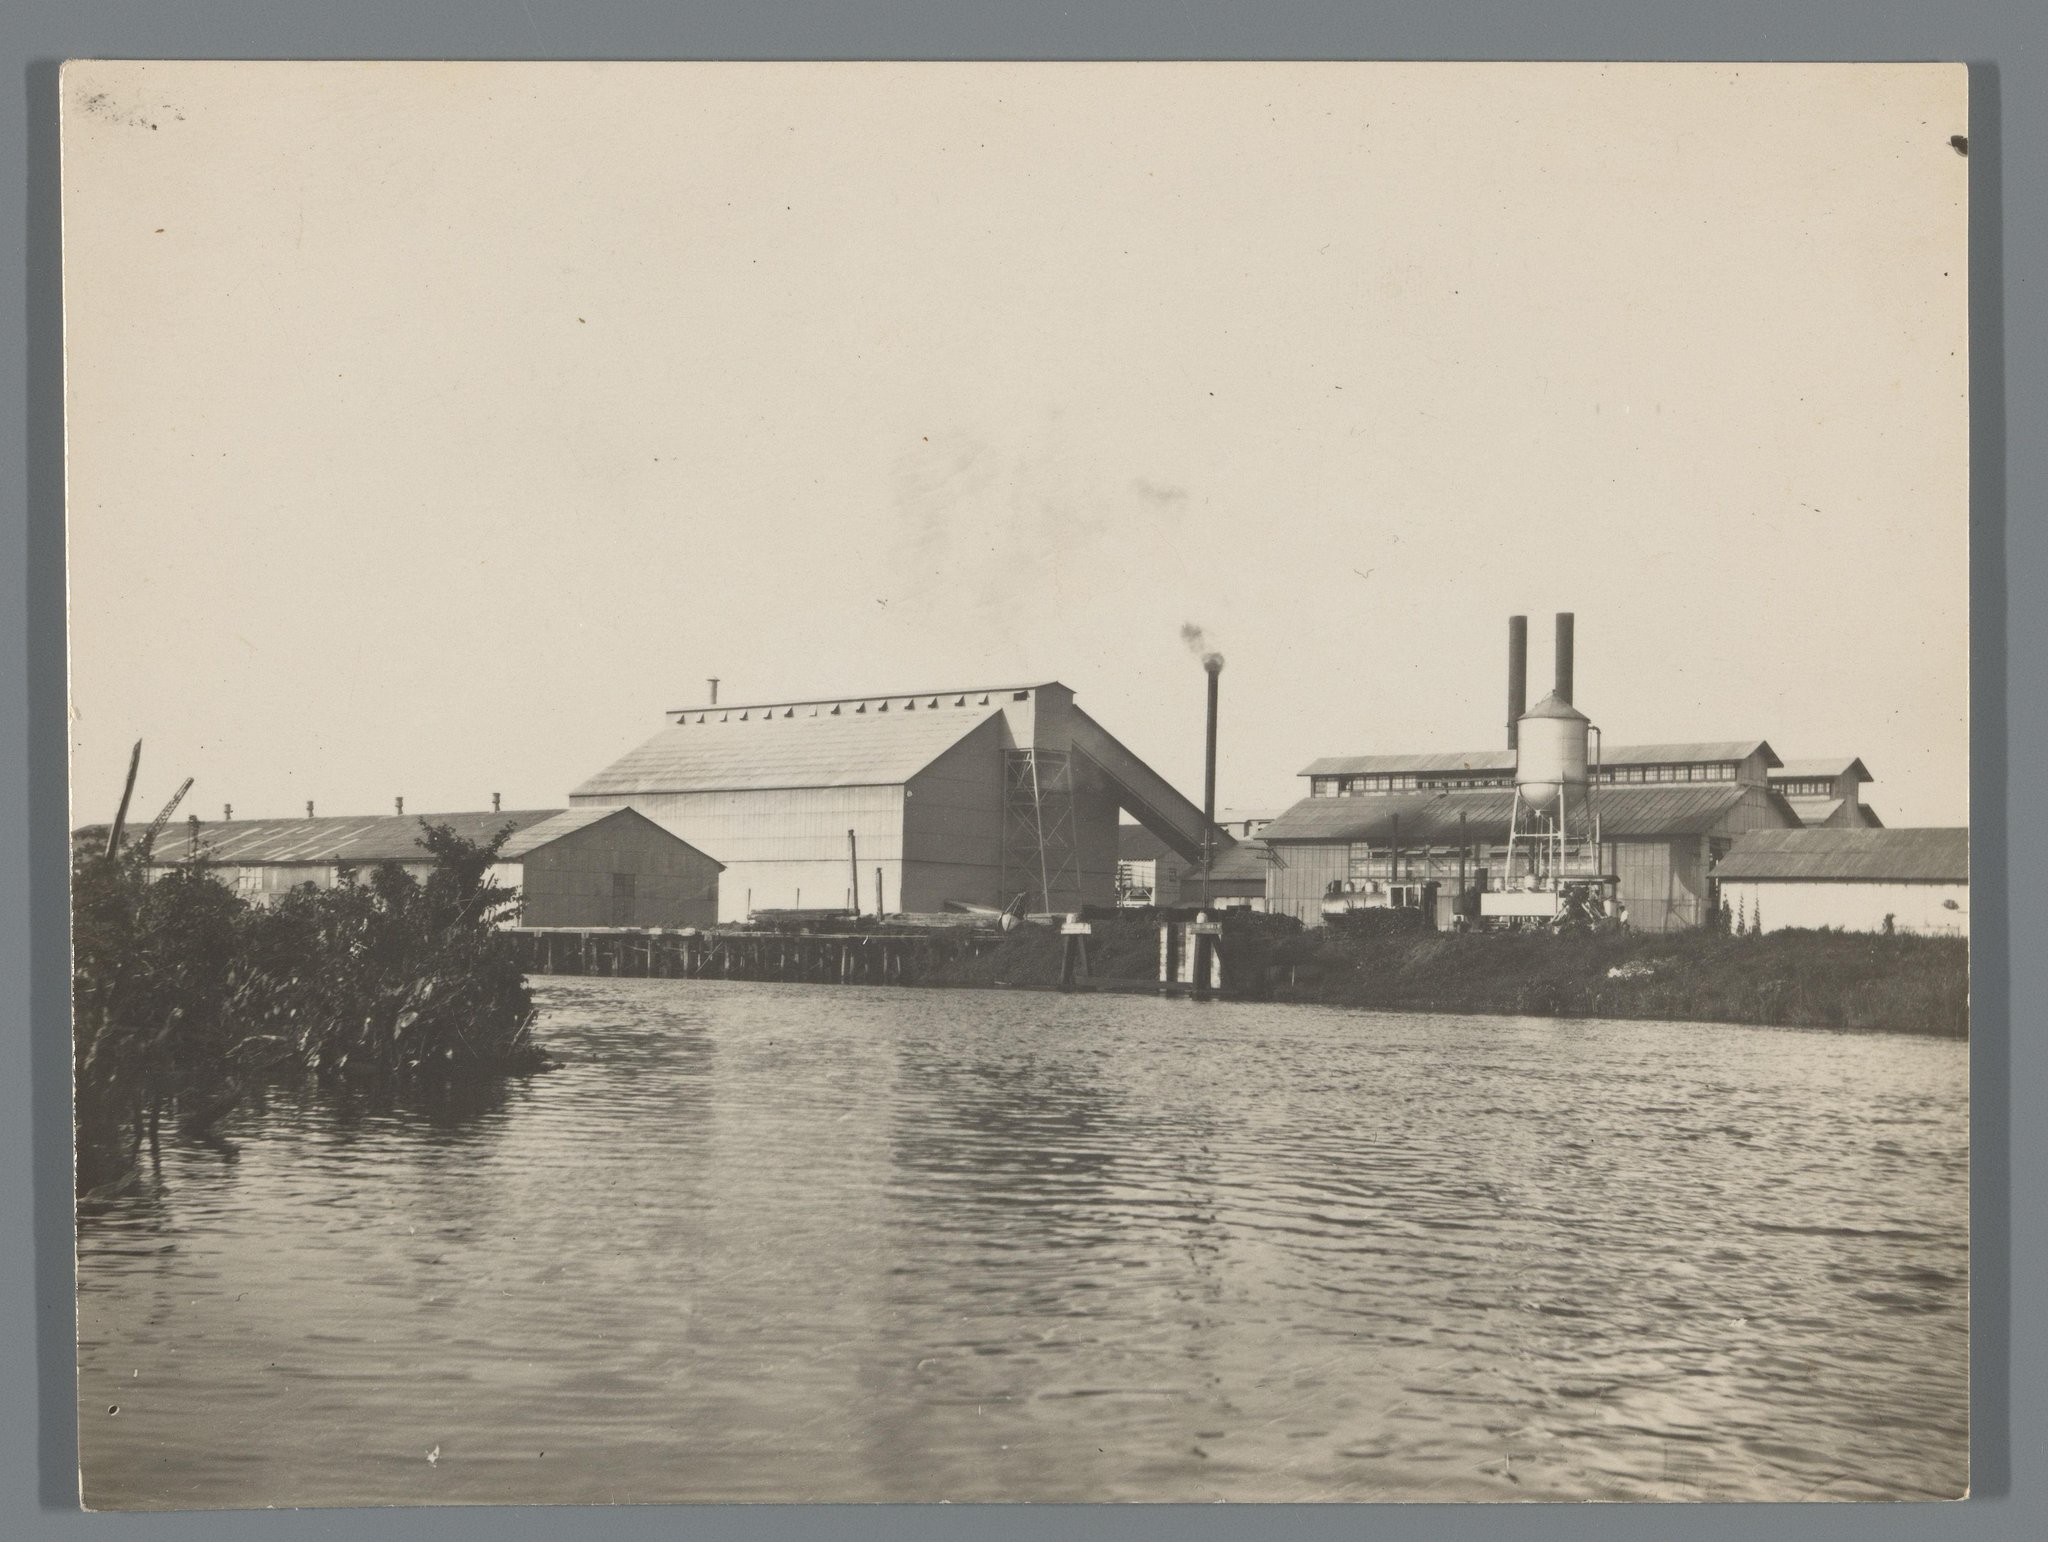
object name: photograph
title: Fabriek te Moengo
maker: Anonymous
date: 1925-1927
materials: photographic support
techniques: photography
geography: suriname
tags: jetten, familie, moengo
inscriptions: inscription: ‘gedeelte plant fabriek’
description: Gezicht op de mijn en fabriek te Moengo van over het water. Onderdeel van het ensemble met foto's van de familie van ingenieur Jetten in de mijnbouwstad Moengo in Suriname.